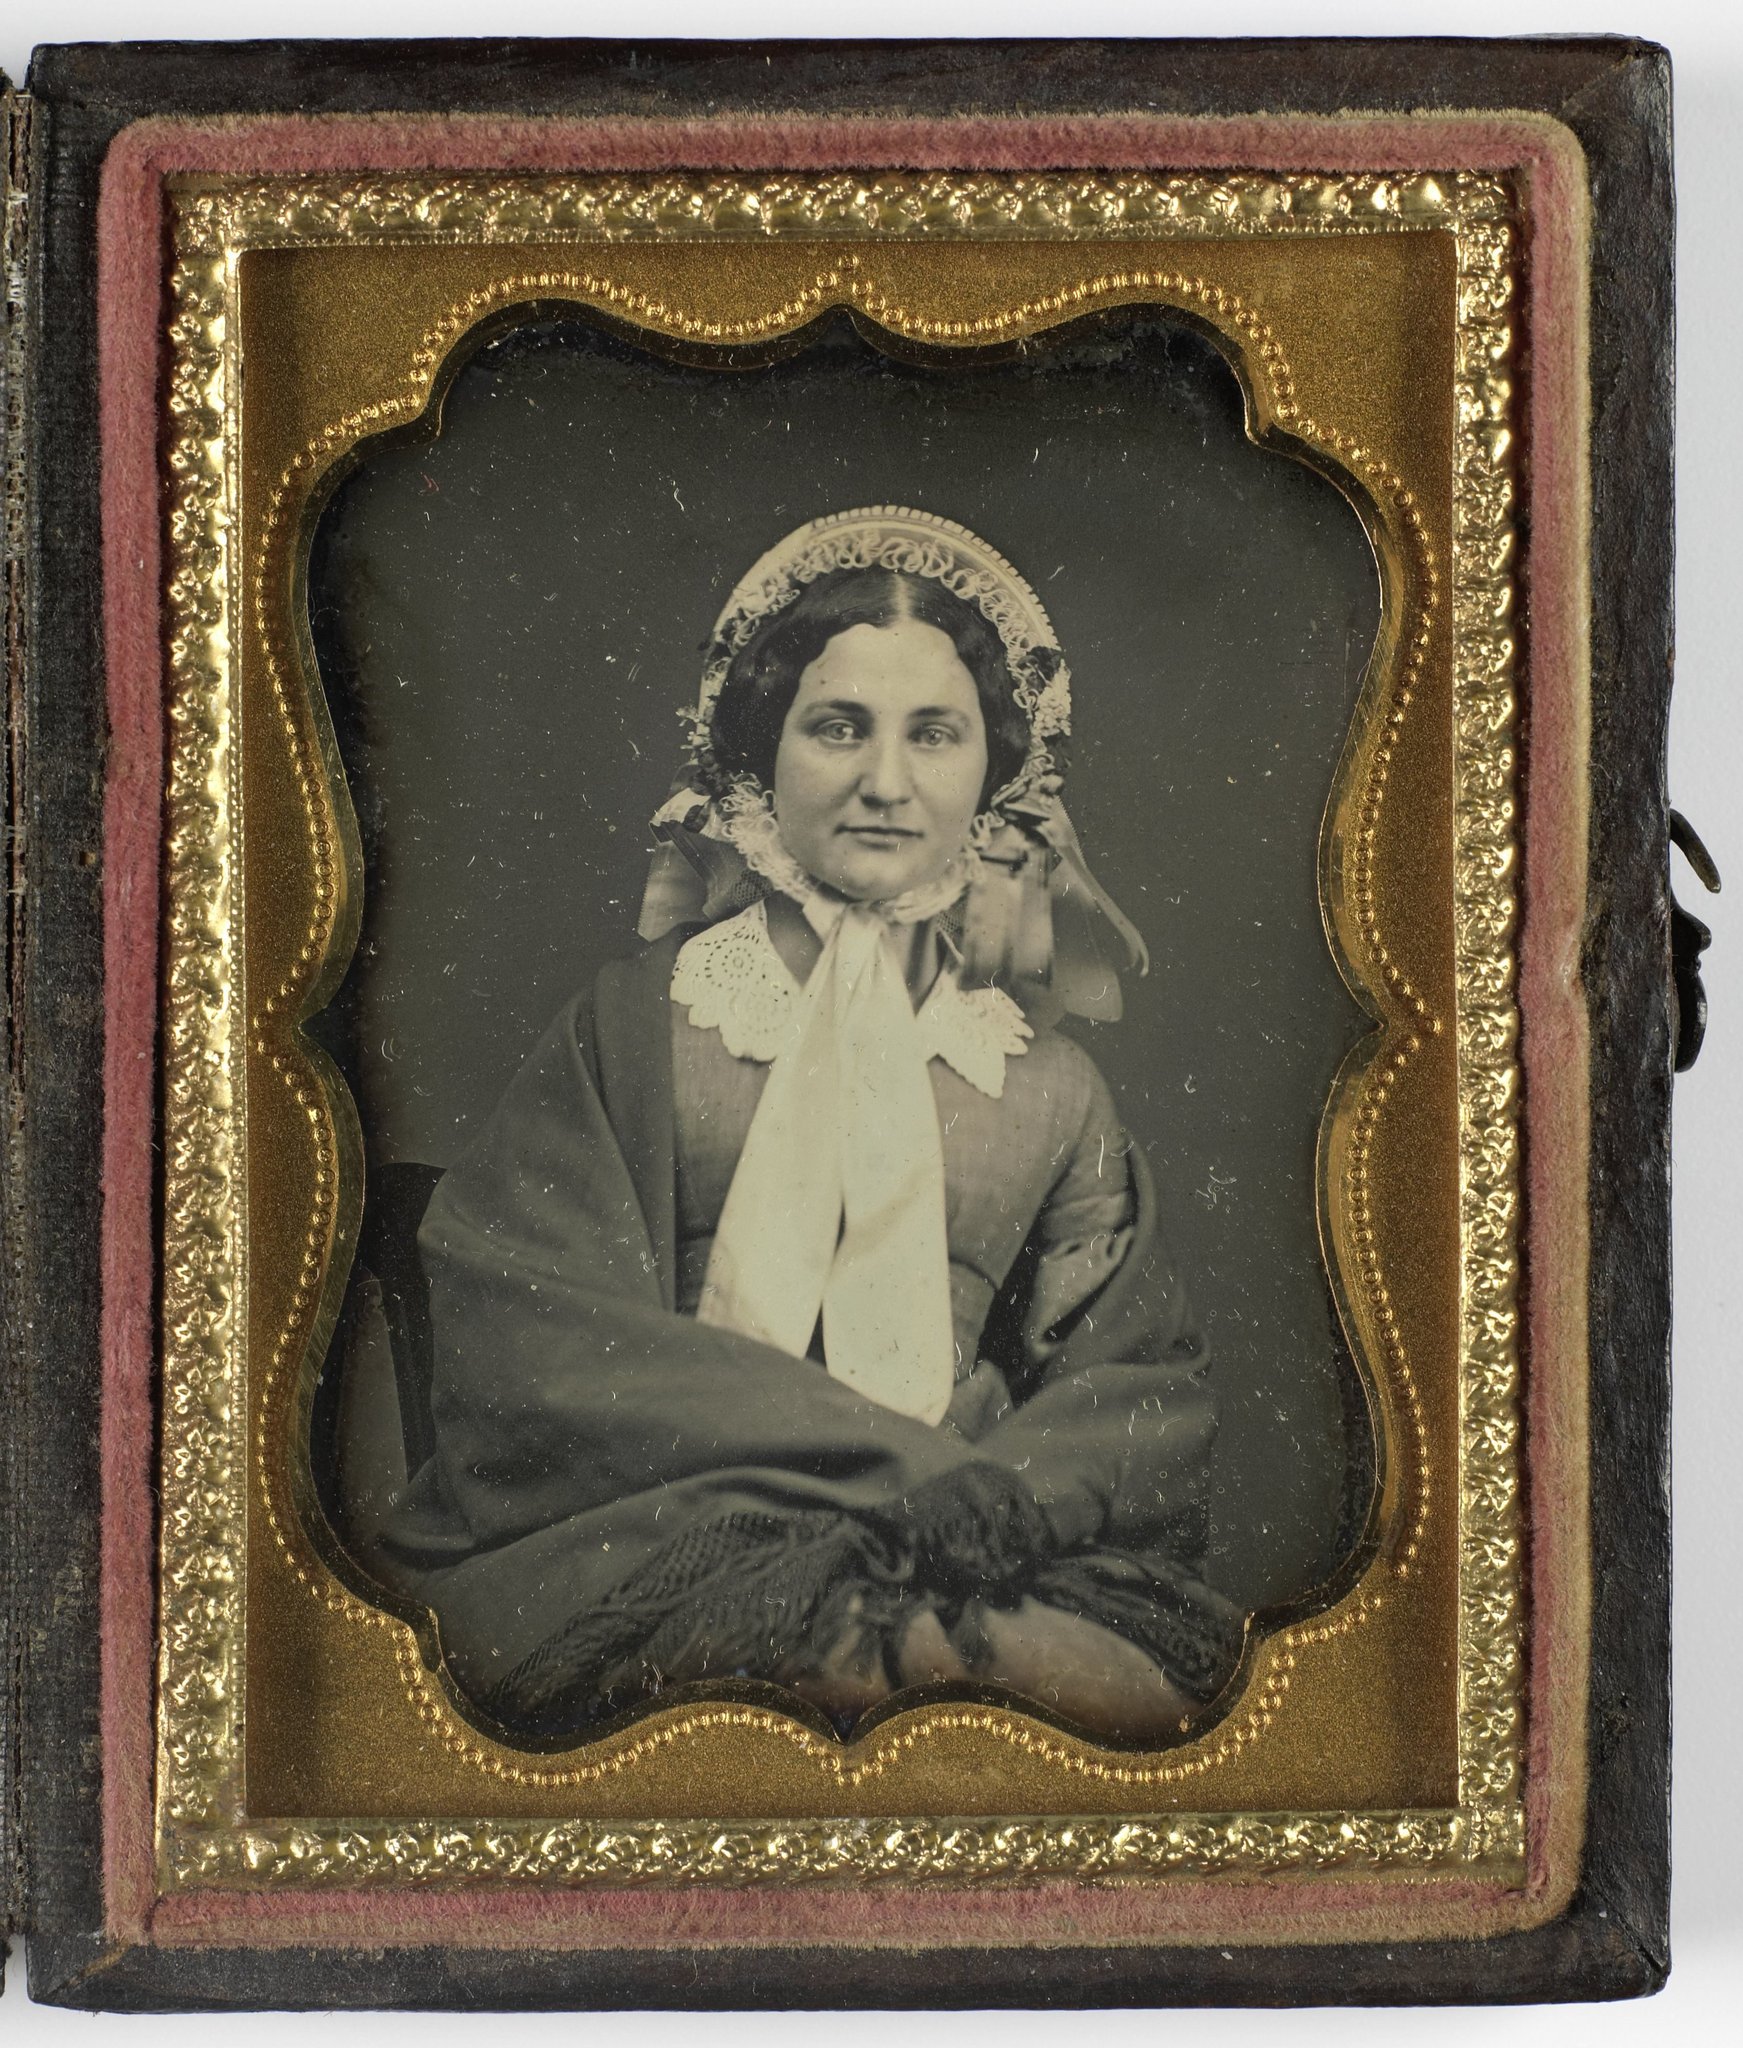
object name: photograph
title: Portret van een onbekende vrouw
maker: Anonymous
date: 1840-1860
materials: copper, glass, leather, velvet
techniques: daguerreotype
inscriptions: inscription: ‘Seth/ Aldrich/ Sherburne/ one no 2’